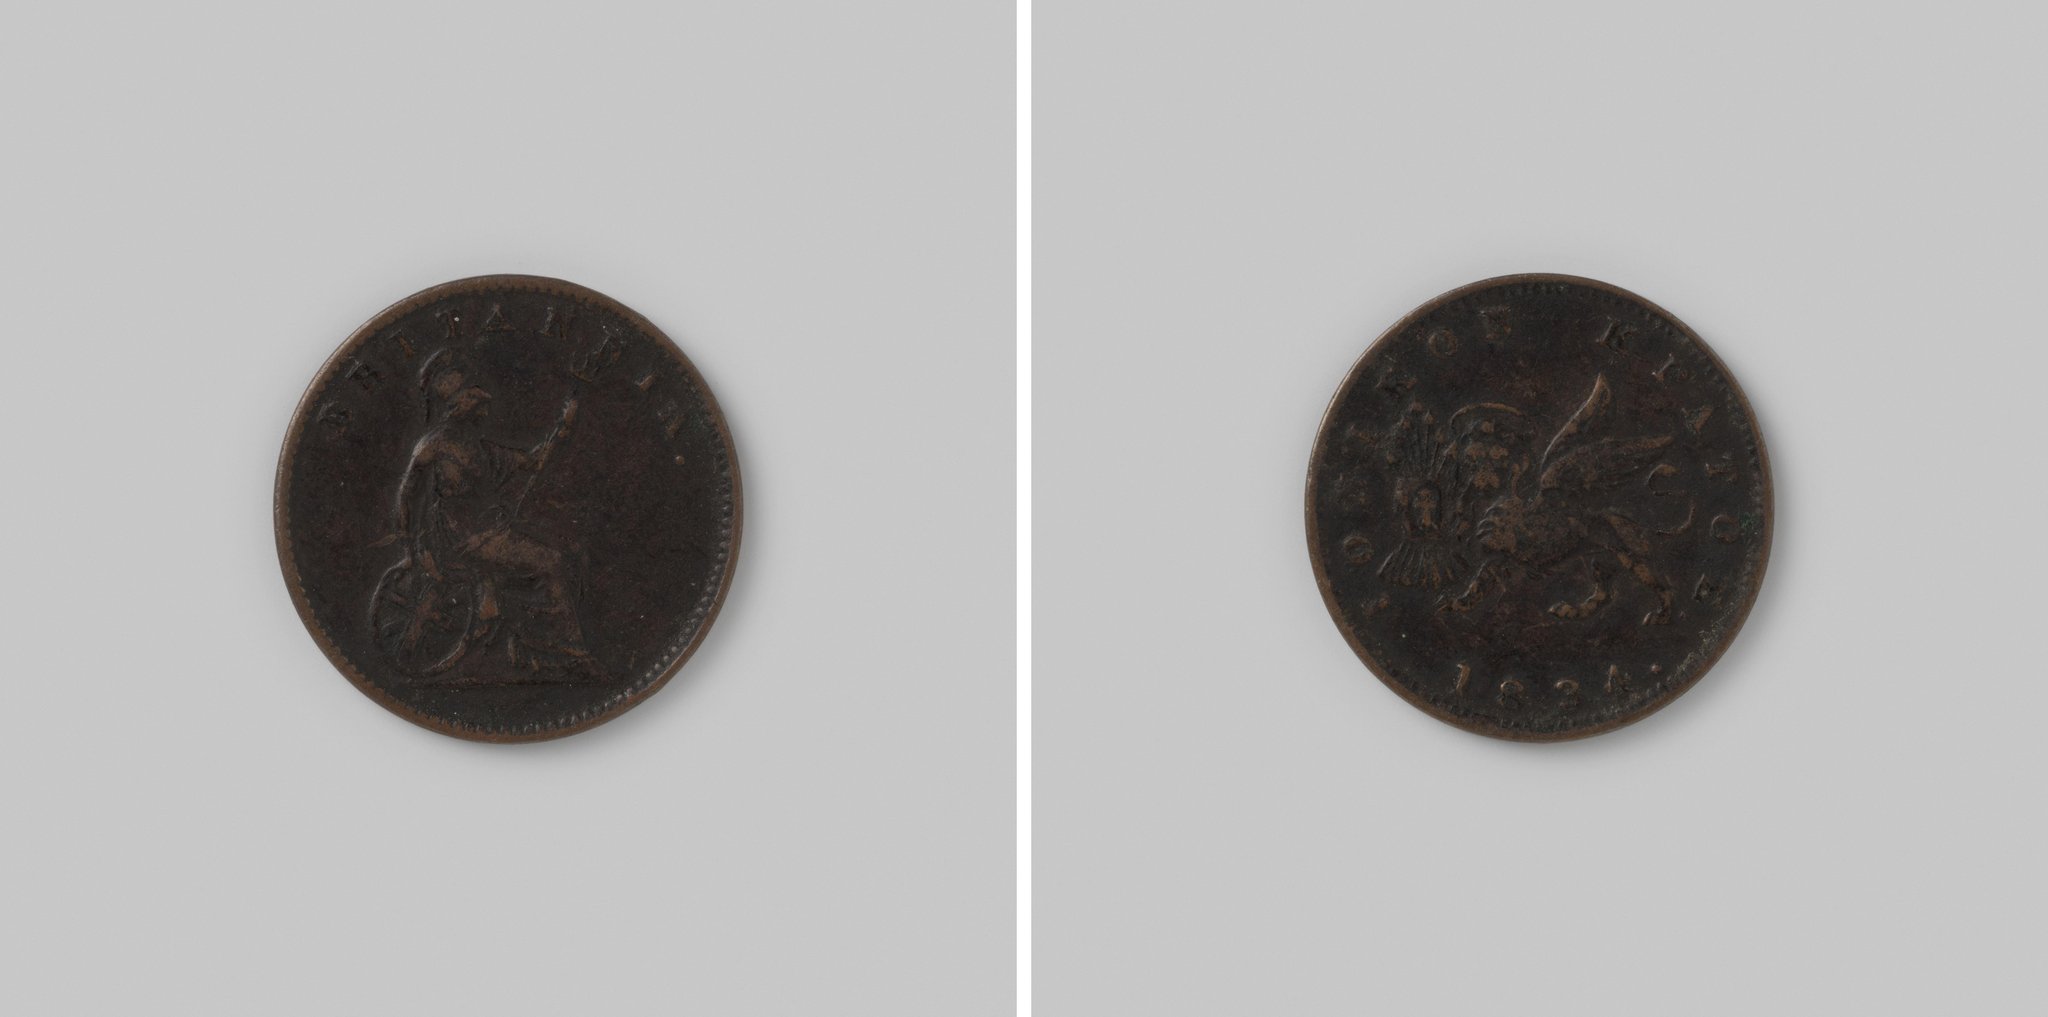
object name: coin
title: Lepton uit de Ionische eilanden onder heerschappij van Groot-Brittannië, 1834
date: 1834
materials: copper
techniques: striking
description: Koperen munt. Voorzijde: Brittannia naar rechts, gezeten op een rots, waartegen een schild, met in haar linkerhand een drietand. Keerzijde: gevleugelde leeuw met in zijn rechterpoot het evangelie, omgeven door een pijlenbundel. Jaartal onderaan. Gladde rand.